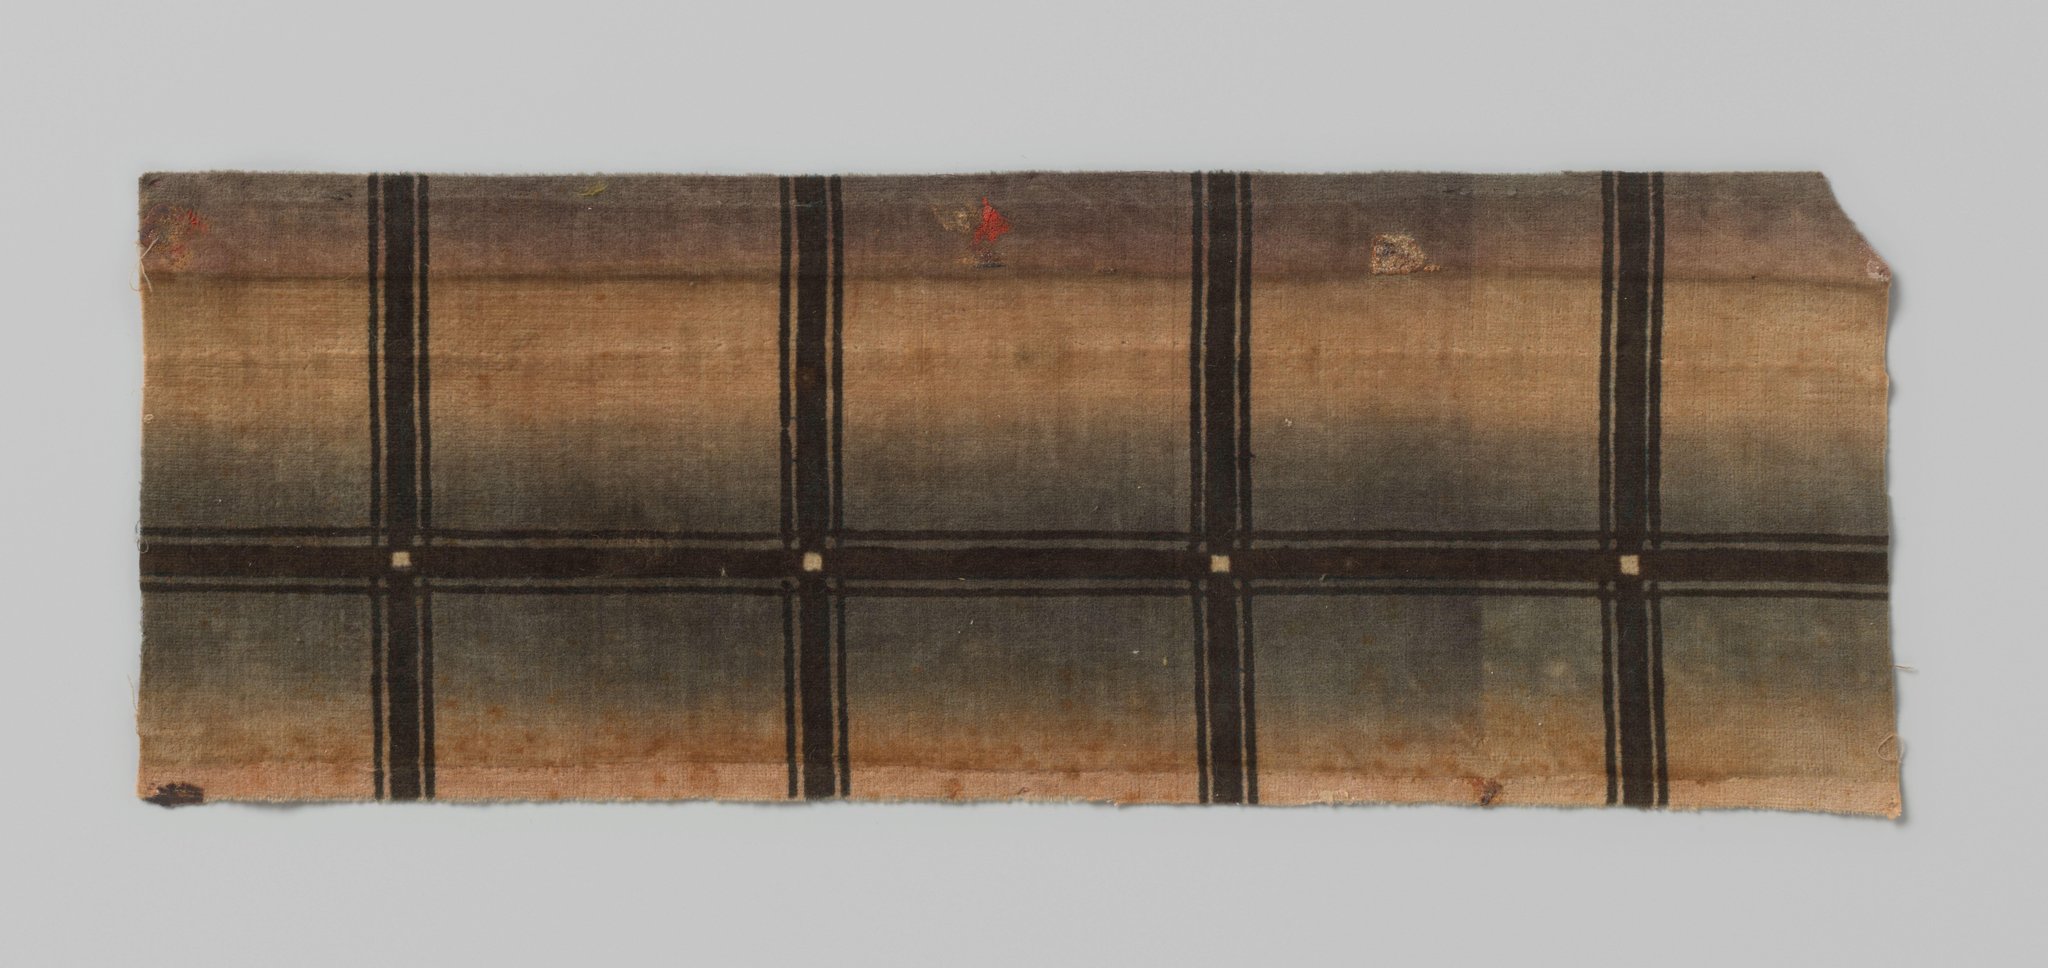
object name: bekledingsstof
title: Fragment bekledingsstof van bedrukte fluweel of trijp met zwarte ruiten op grijsblauwe of paarse grond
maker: Anonymous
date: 1740-1760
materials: textile, velvet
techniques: printing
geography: france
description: Fragment bekledingsstof van bedrukte fluweel of trijp met zwarte, horizontale en verticale banen en witte ruiten. Verkleurd.